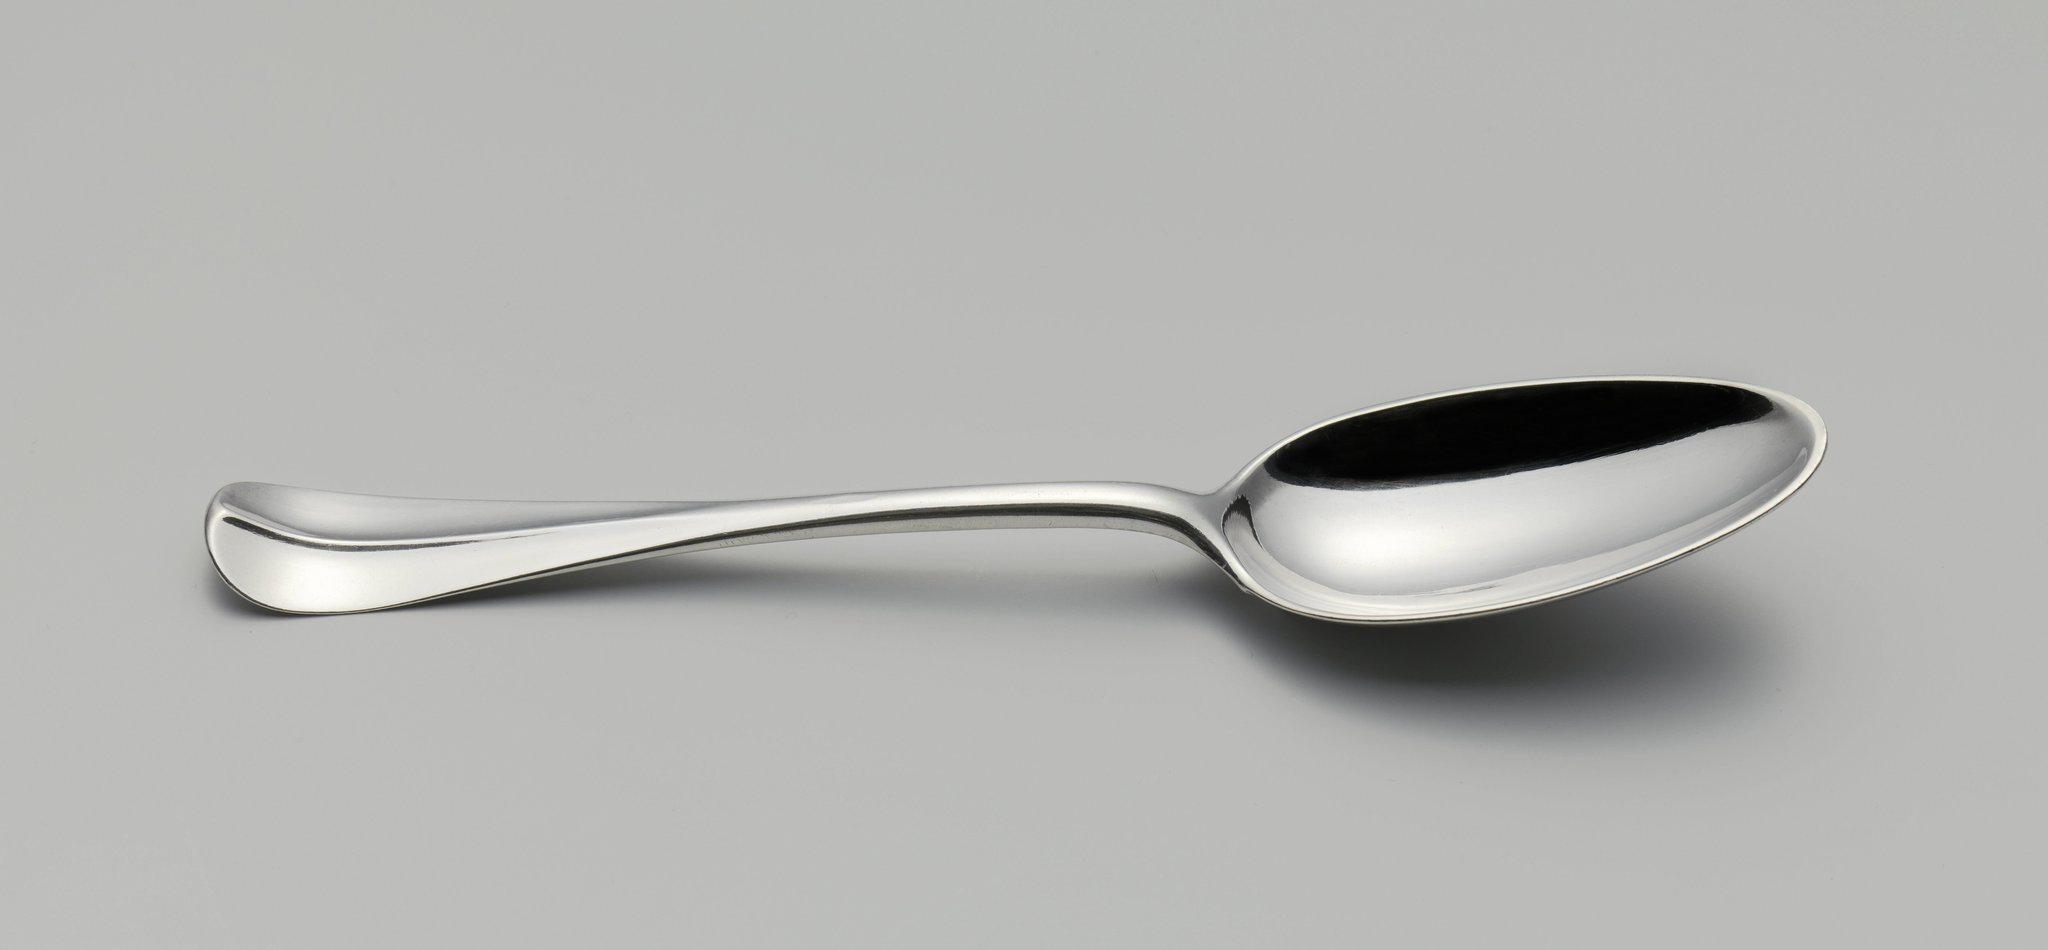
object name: spoon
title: Lepel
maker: rudolphus sondagh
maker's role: print maker, silversmith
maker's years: 1726-1812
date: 1789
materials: silver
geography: rotterdam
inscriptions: mark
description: Lepel van zilver, met een eivormige bak. De platte, gebogen steel verbreedt zich naar het afgeronde uiteinde.